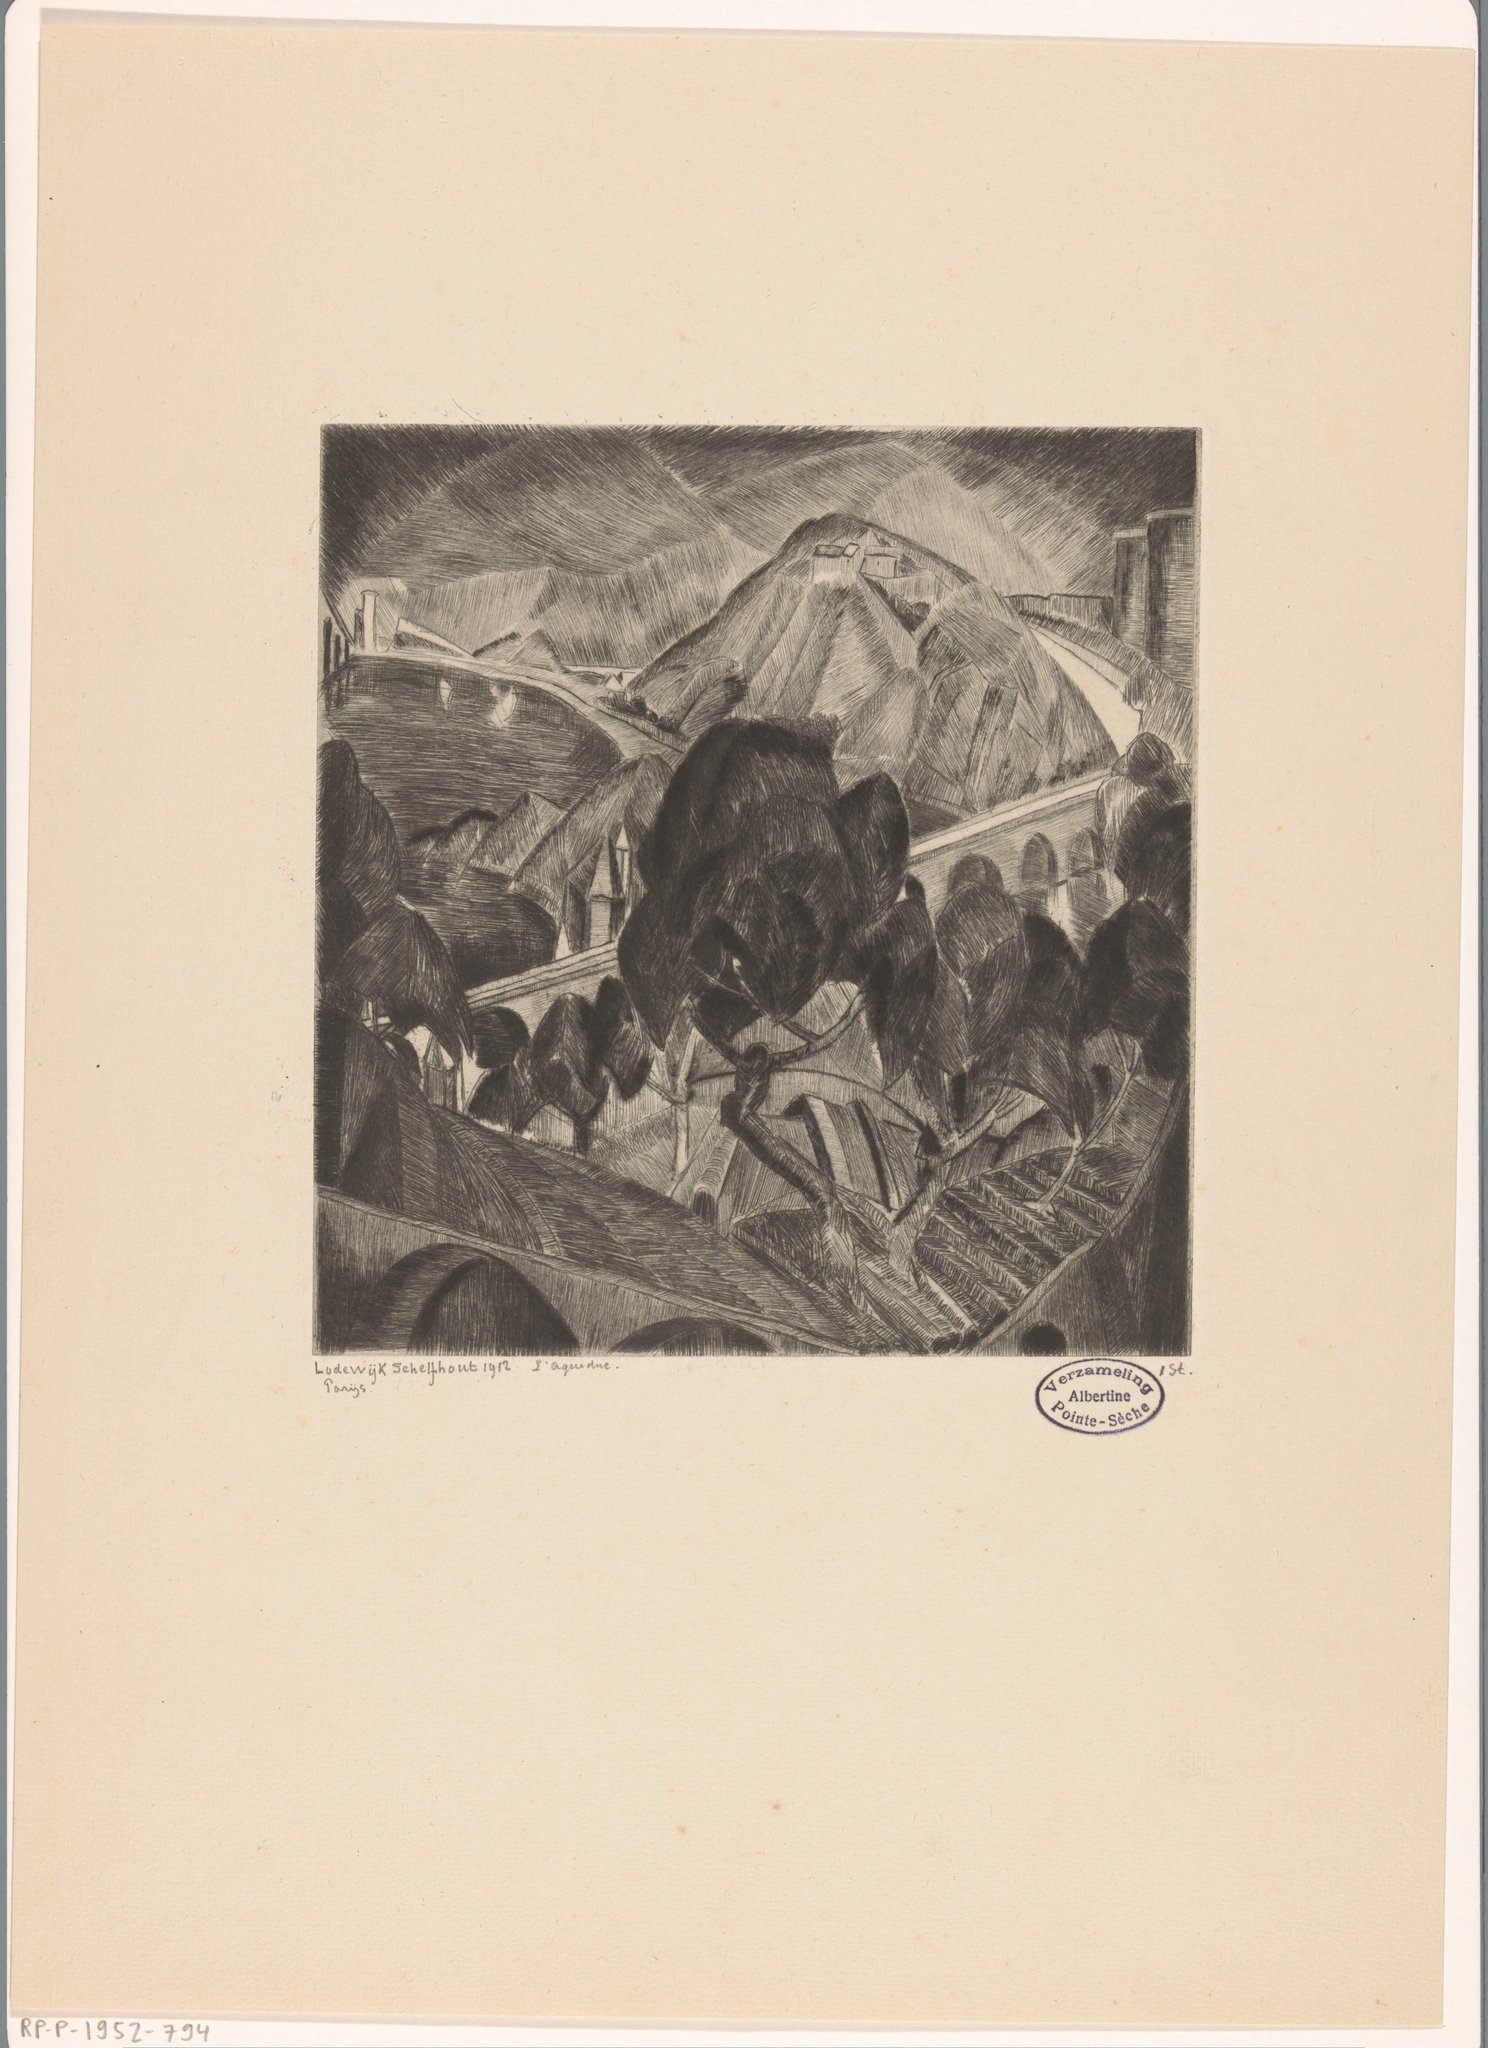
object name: print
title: L'Aqueduc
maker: lodewijk schelfhout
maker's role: draughtsman, print maker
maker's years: 1881-1943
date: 1912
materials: paper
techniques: drypoint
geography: paris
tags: aqueduct (~ water supply), mountains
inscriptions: collector's mark: Lugt 5i, collector's mark: Lugt 2760, collector's mark: Lugt 2228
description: Een berglandschap langs een baai. Op de voorgrond bomen en een aquaduct.